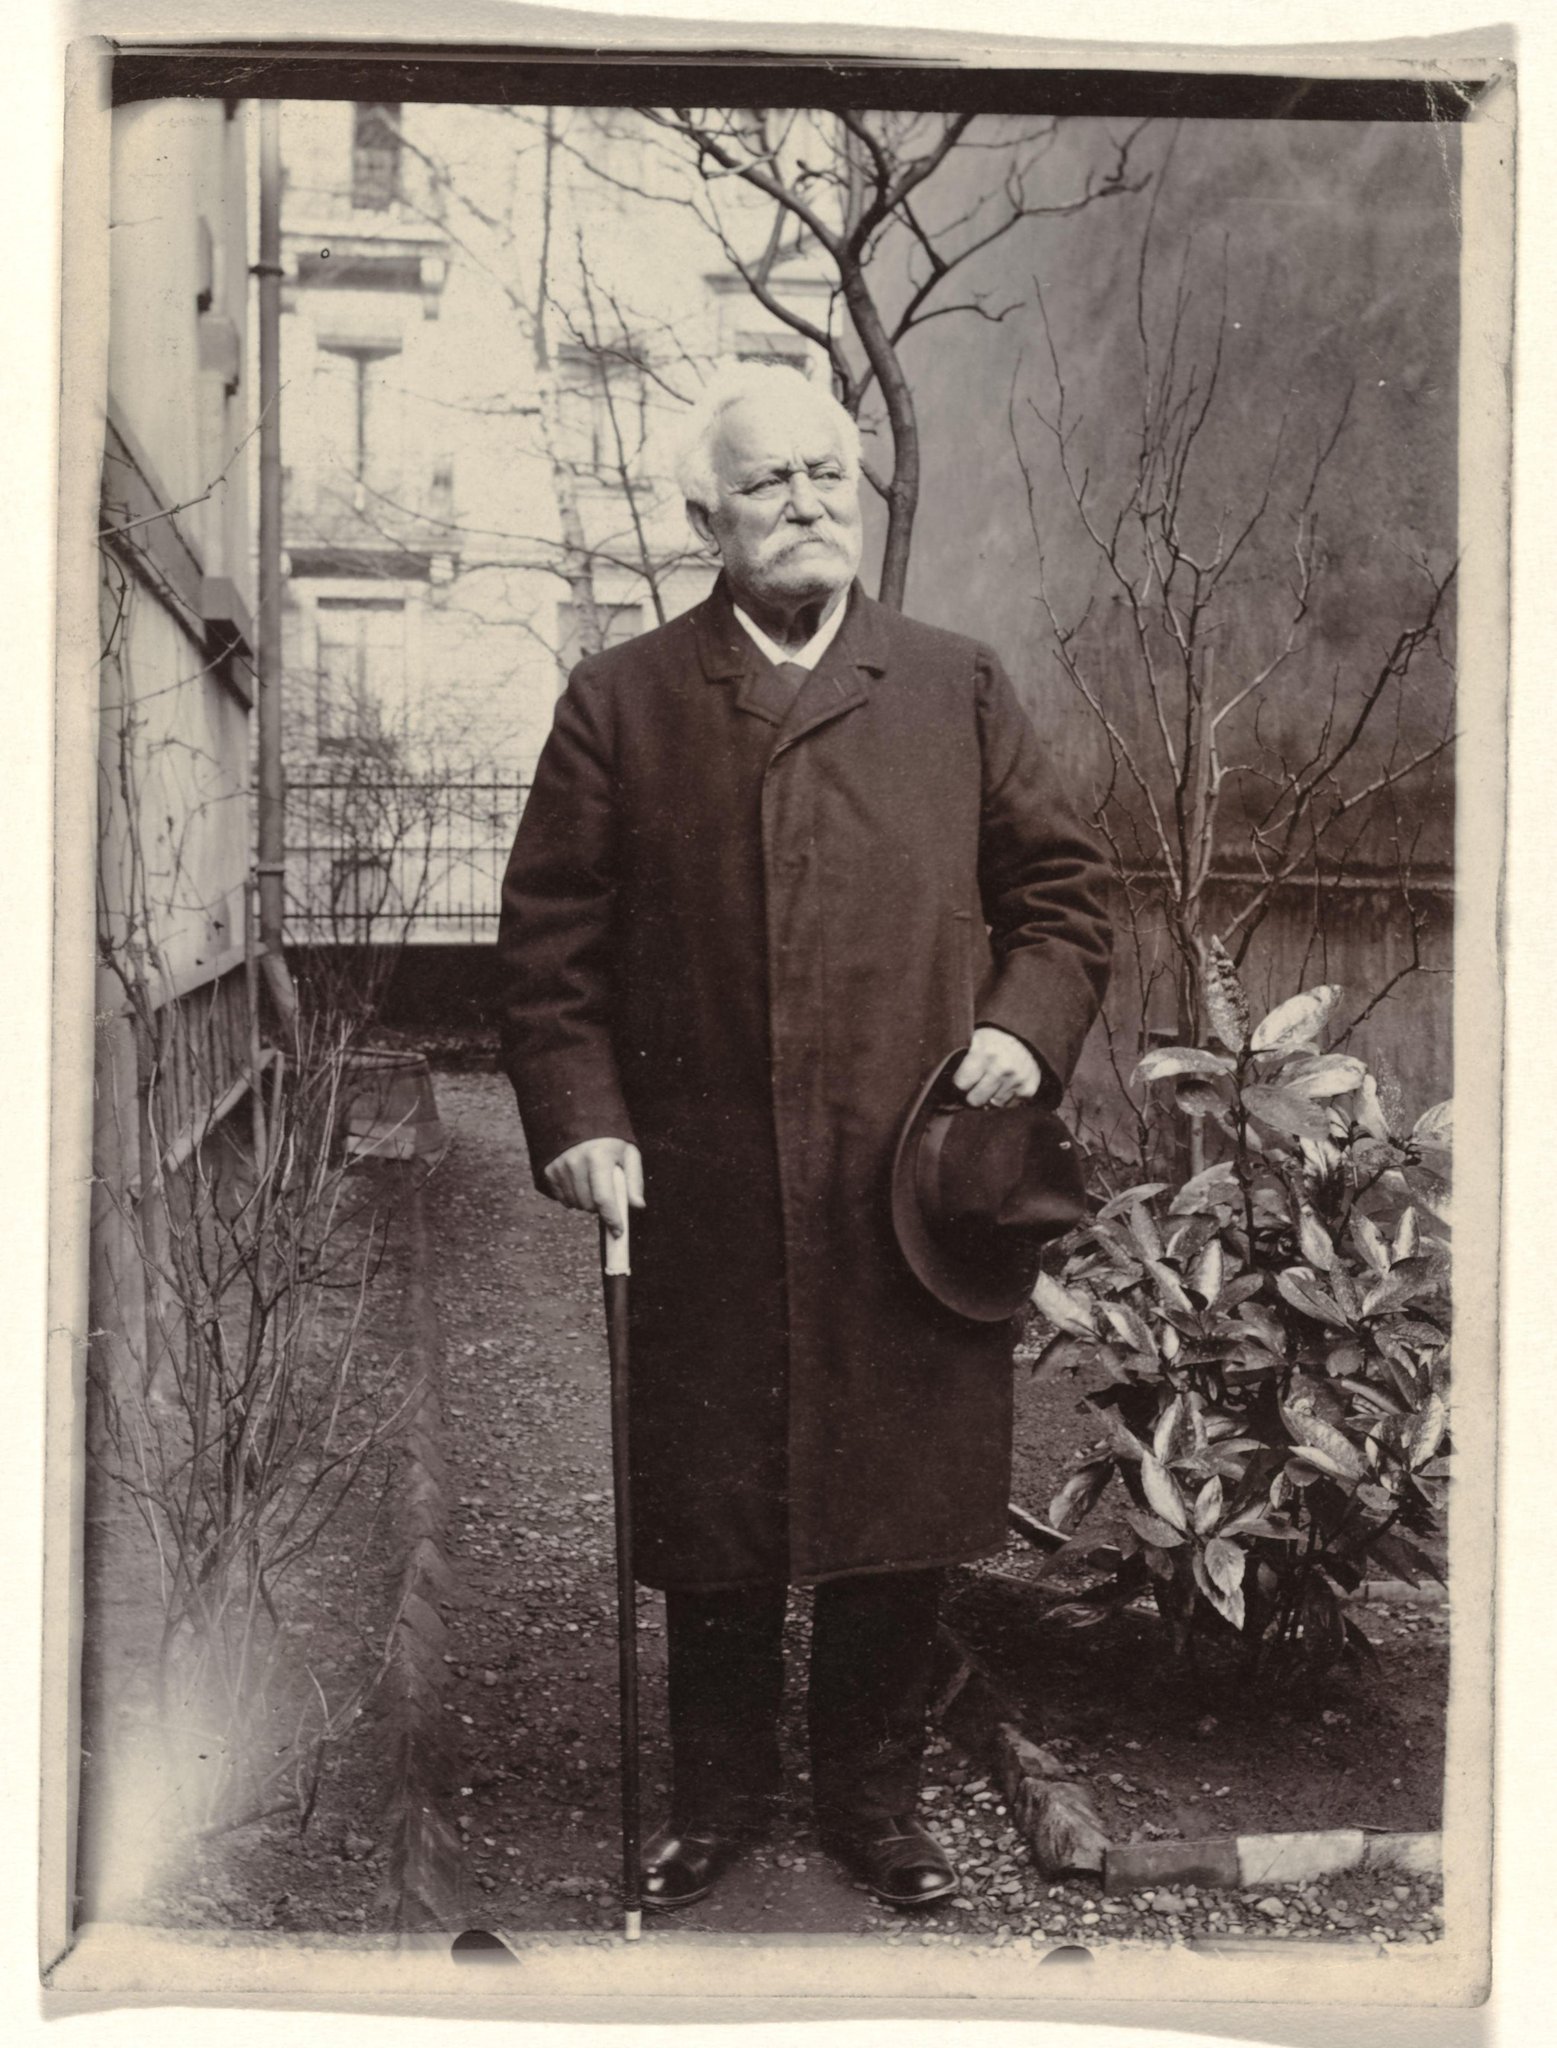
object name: photograph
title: Oudere man met snor, en loopstok en hoed in zijn handen, staand voor een gebouw, met begroeiing naast hem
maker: Anonymous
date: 1890-1940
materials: photographic support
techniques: gelatin silver print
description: Oudere man met snor, en loopstok en hoed in zijn handen, staand voor een gebouw, met begroeiing naast hem.